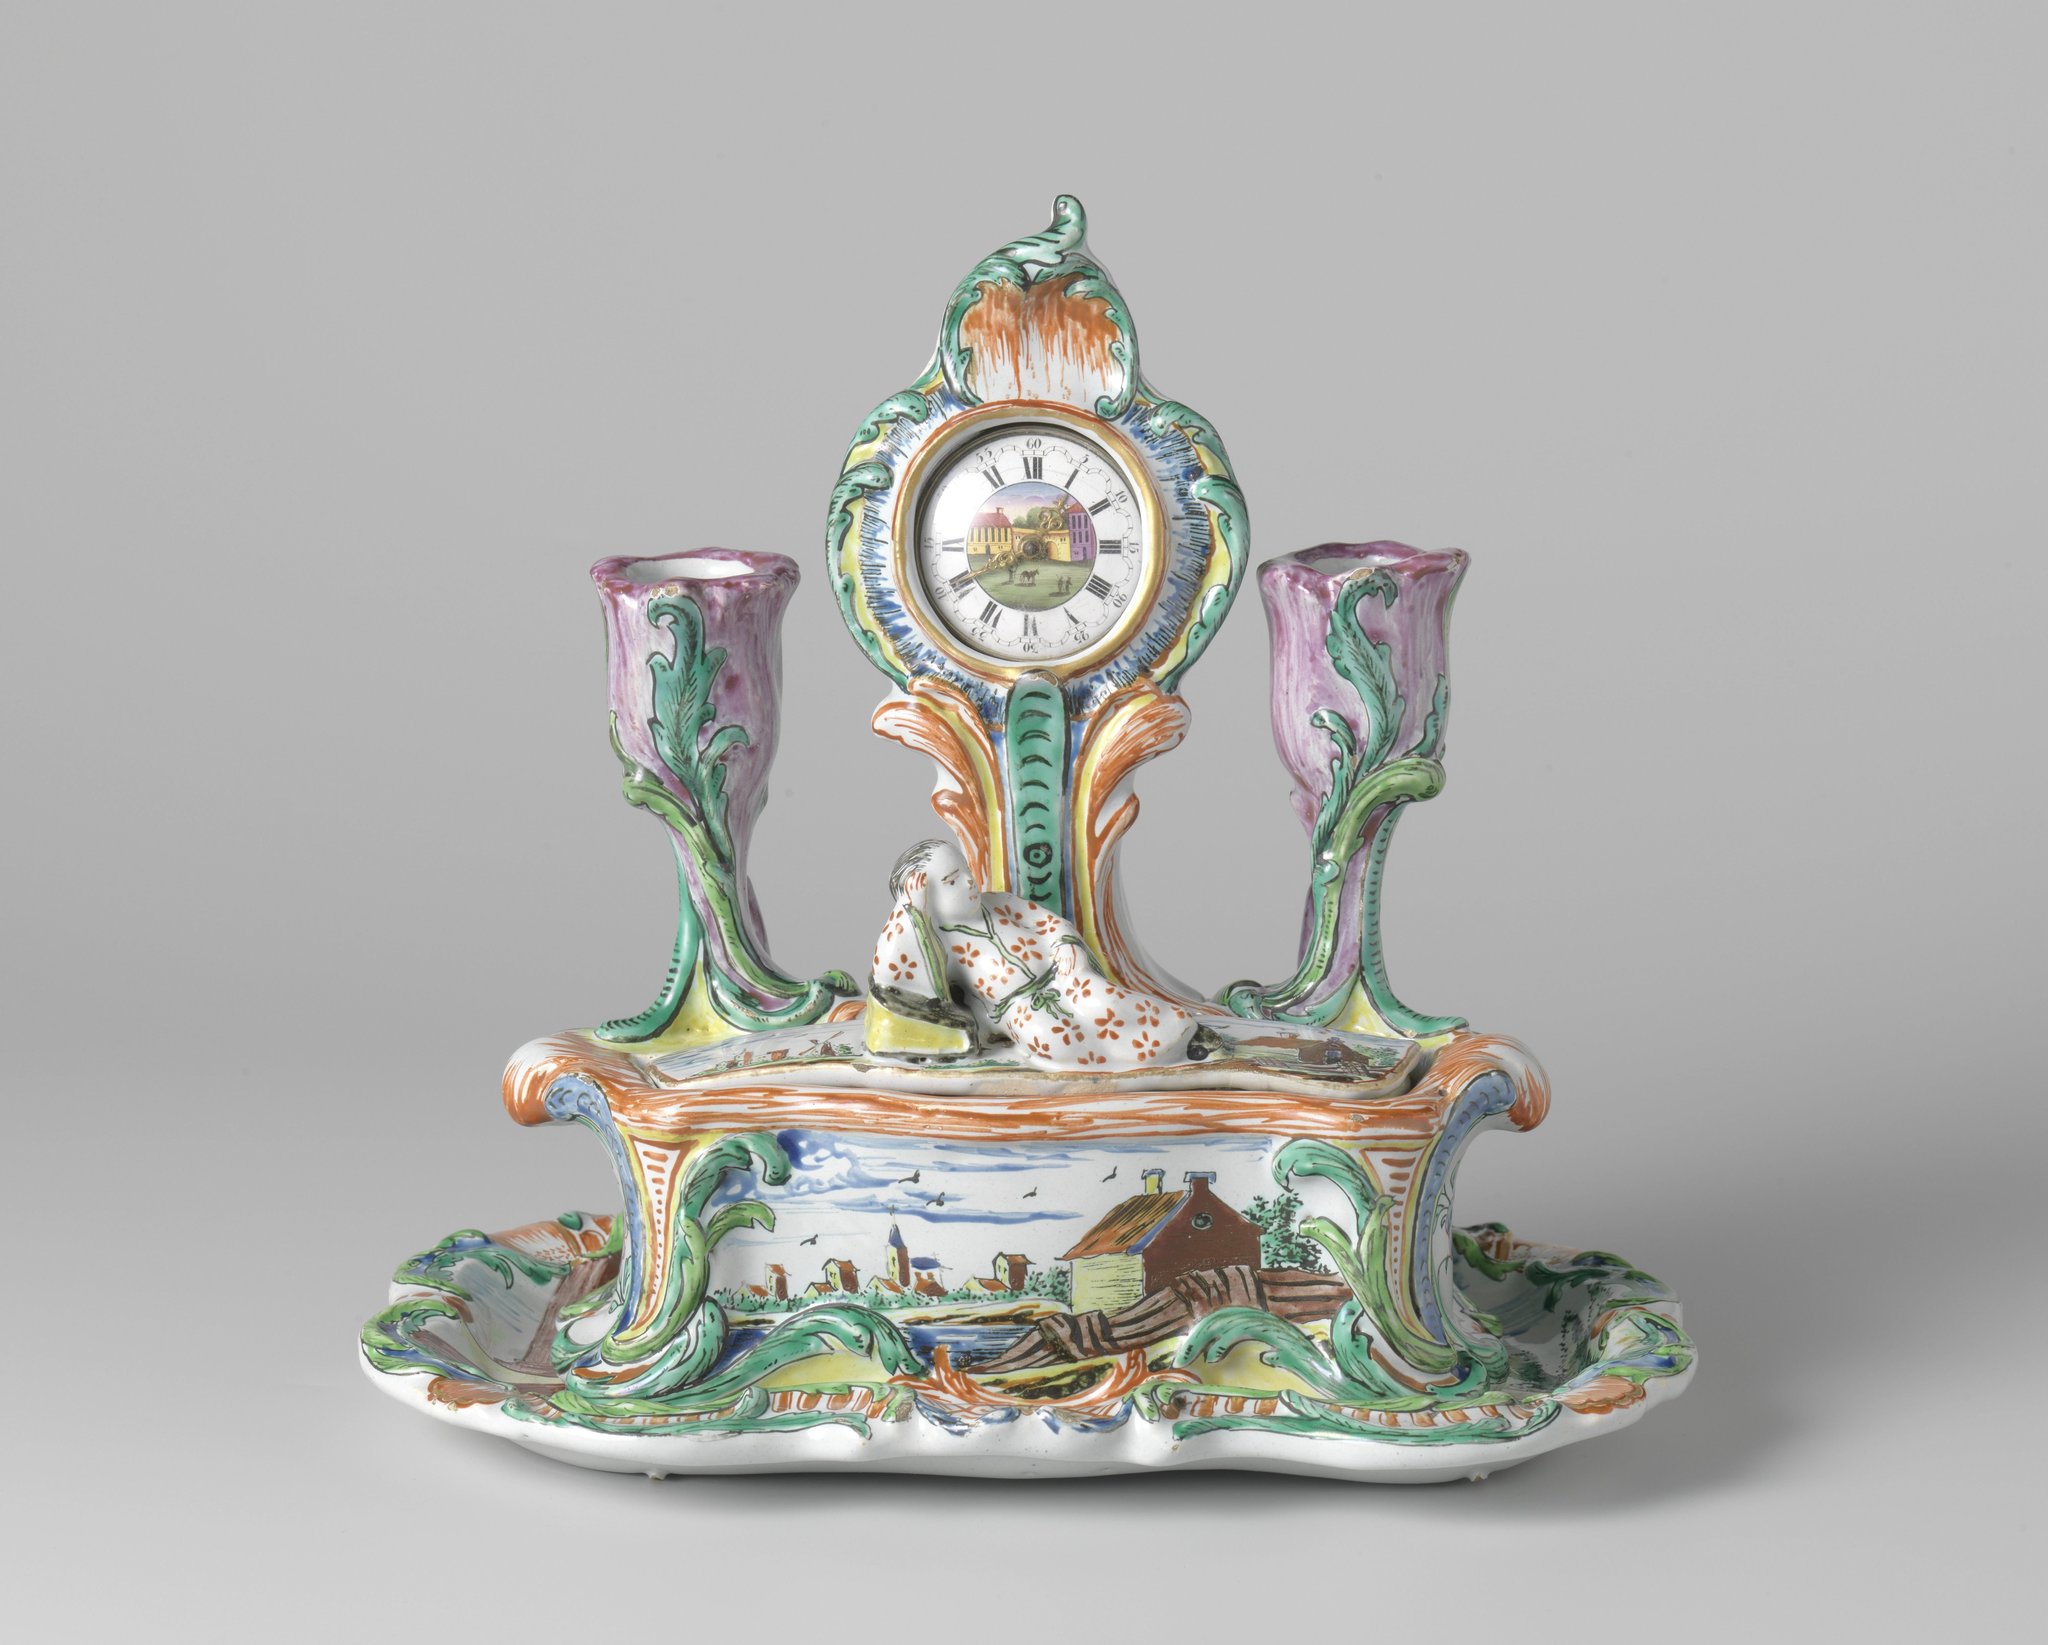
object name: horlogestandaard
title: Inkstand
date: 1750-1782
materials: earthenware, glaze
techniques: kiln, painted, polychromy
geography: delft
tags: landscapes in the temperate zone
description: Deksel van inktstel. Op een in opzet rechthoekig onderstuk bevindt zich in het midden een horlogehouder geflankeerd door kaarsenhouders in rocaillevormen. Het inktstel is geschilderd met een waterlandschap en de onderschotel met een schrijvende figuur omgeven door classicistische gebouwen. Op het deksel een Chinees (?), gekleed in kamerjas.